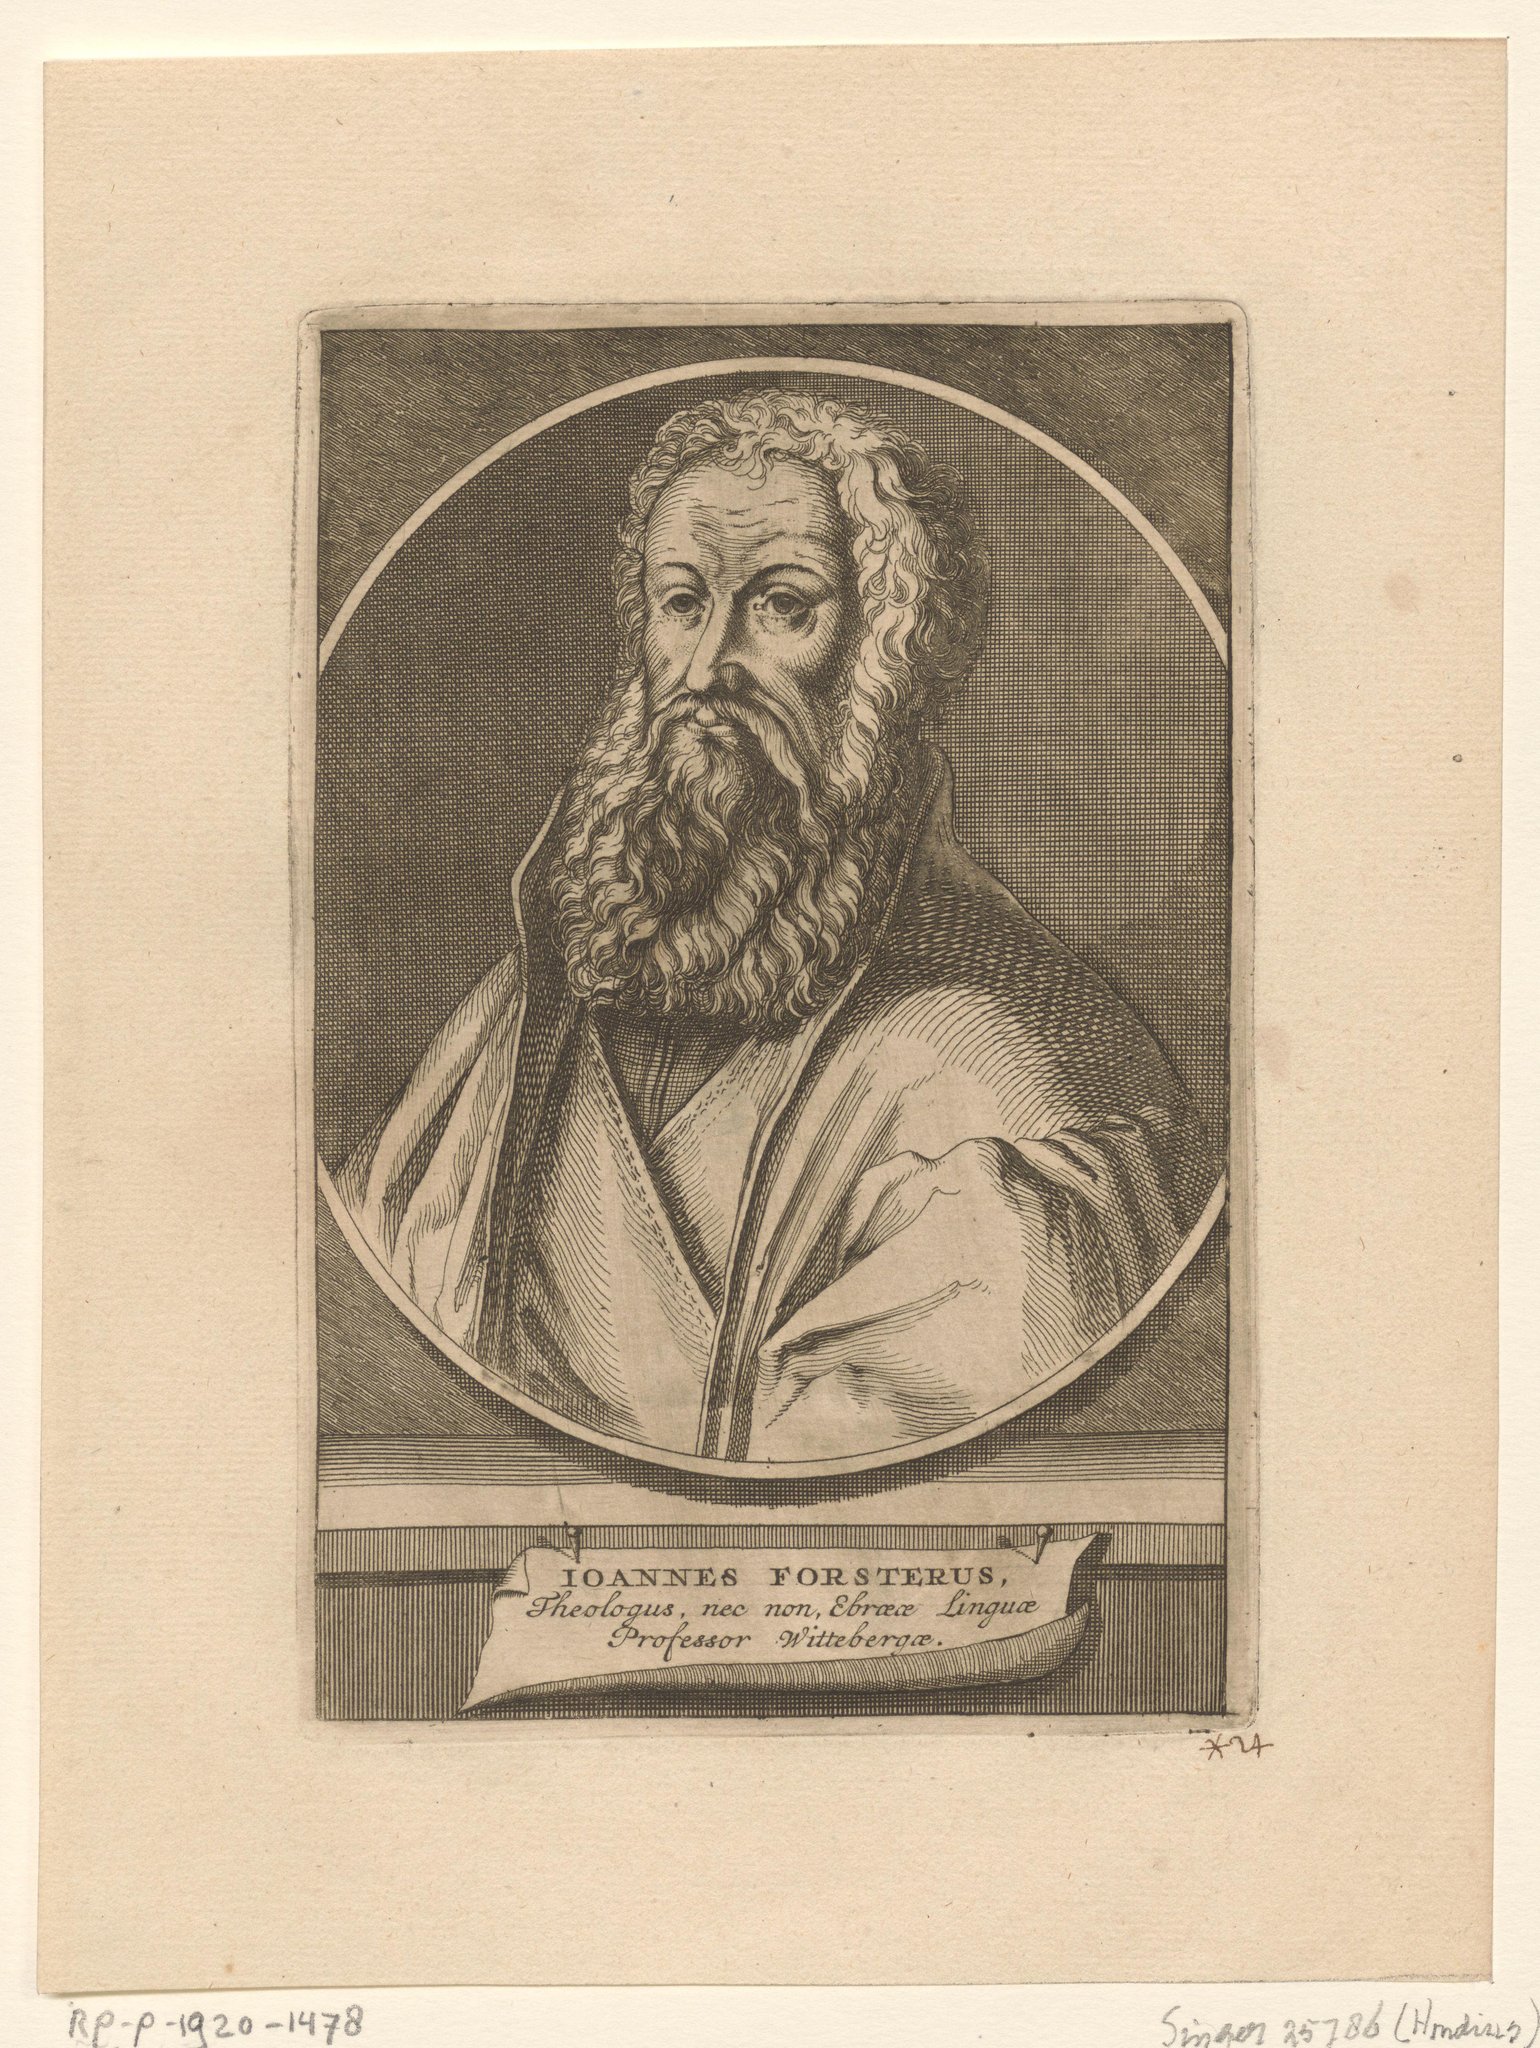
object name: print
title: Portret van Johann Forster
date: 1690-1729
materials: paper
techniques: etching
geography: leiden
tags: augsburg, theologian, historical persons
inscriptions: number: ‘*24’, collector's mark: Lugt 2228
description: Prent waarschijnlijk uit een editie van: Le miroir des portraits des premiers reformateurs des eglises protestantes. Leiden: Pieter van der Aa, [1690-1729]. Eerdere staat gebruikt in serie uit 1599 en publicaties uit 1602 en 1604.